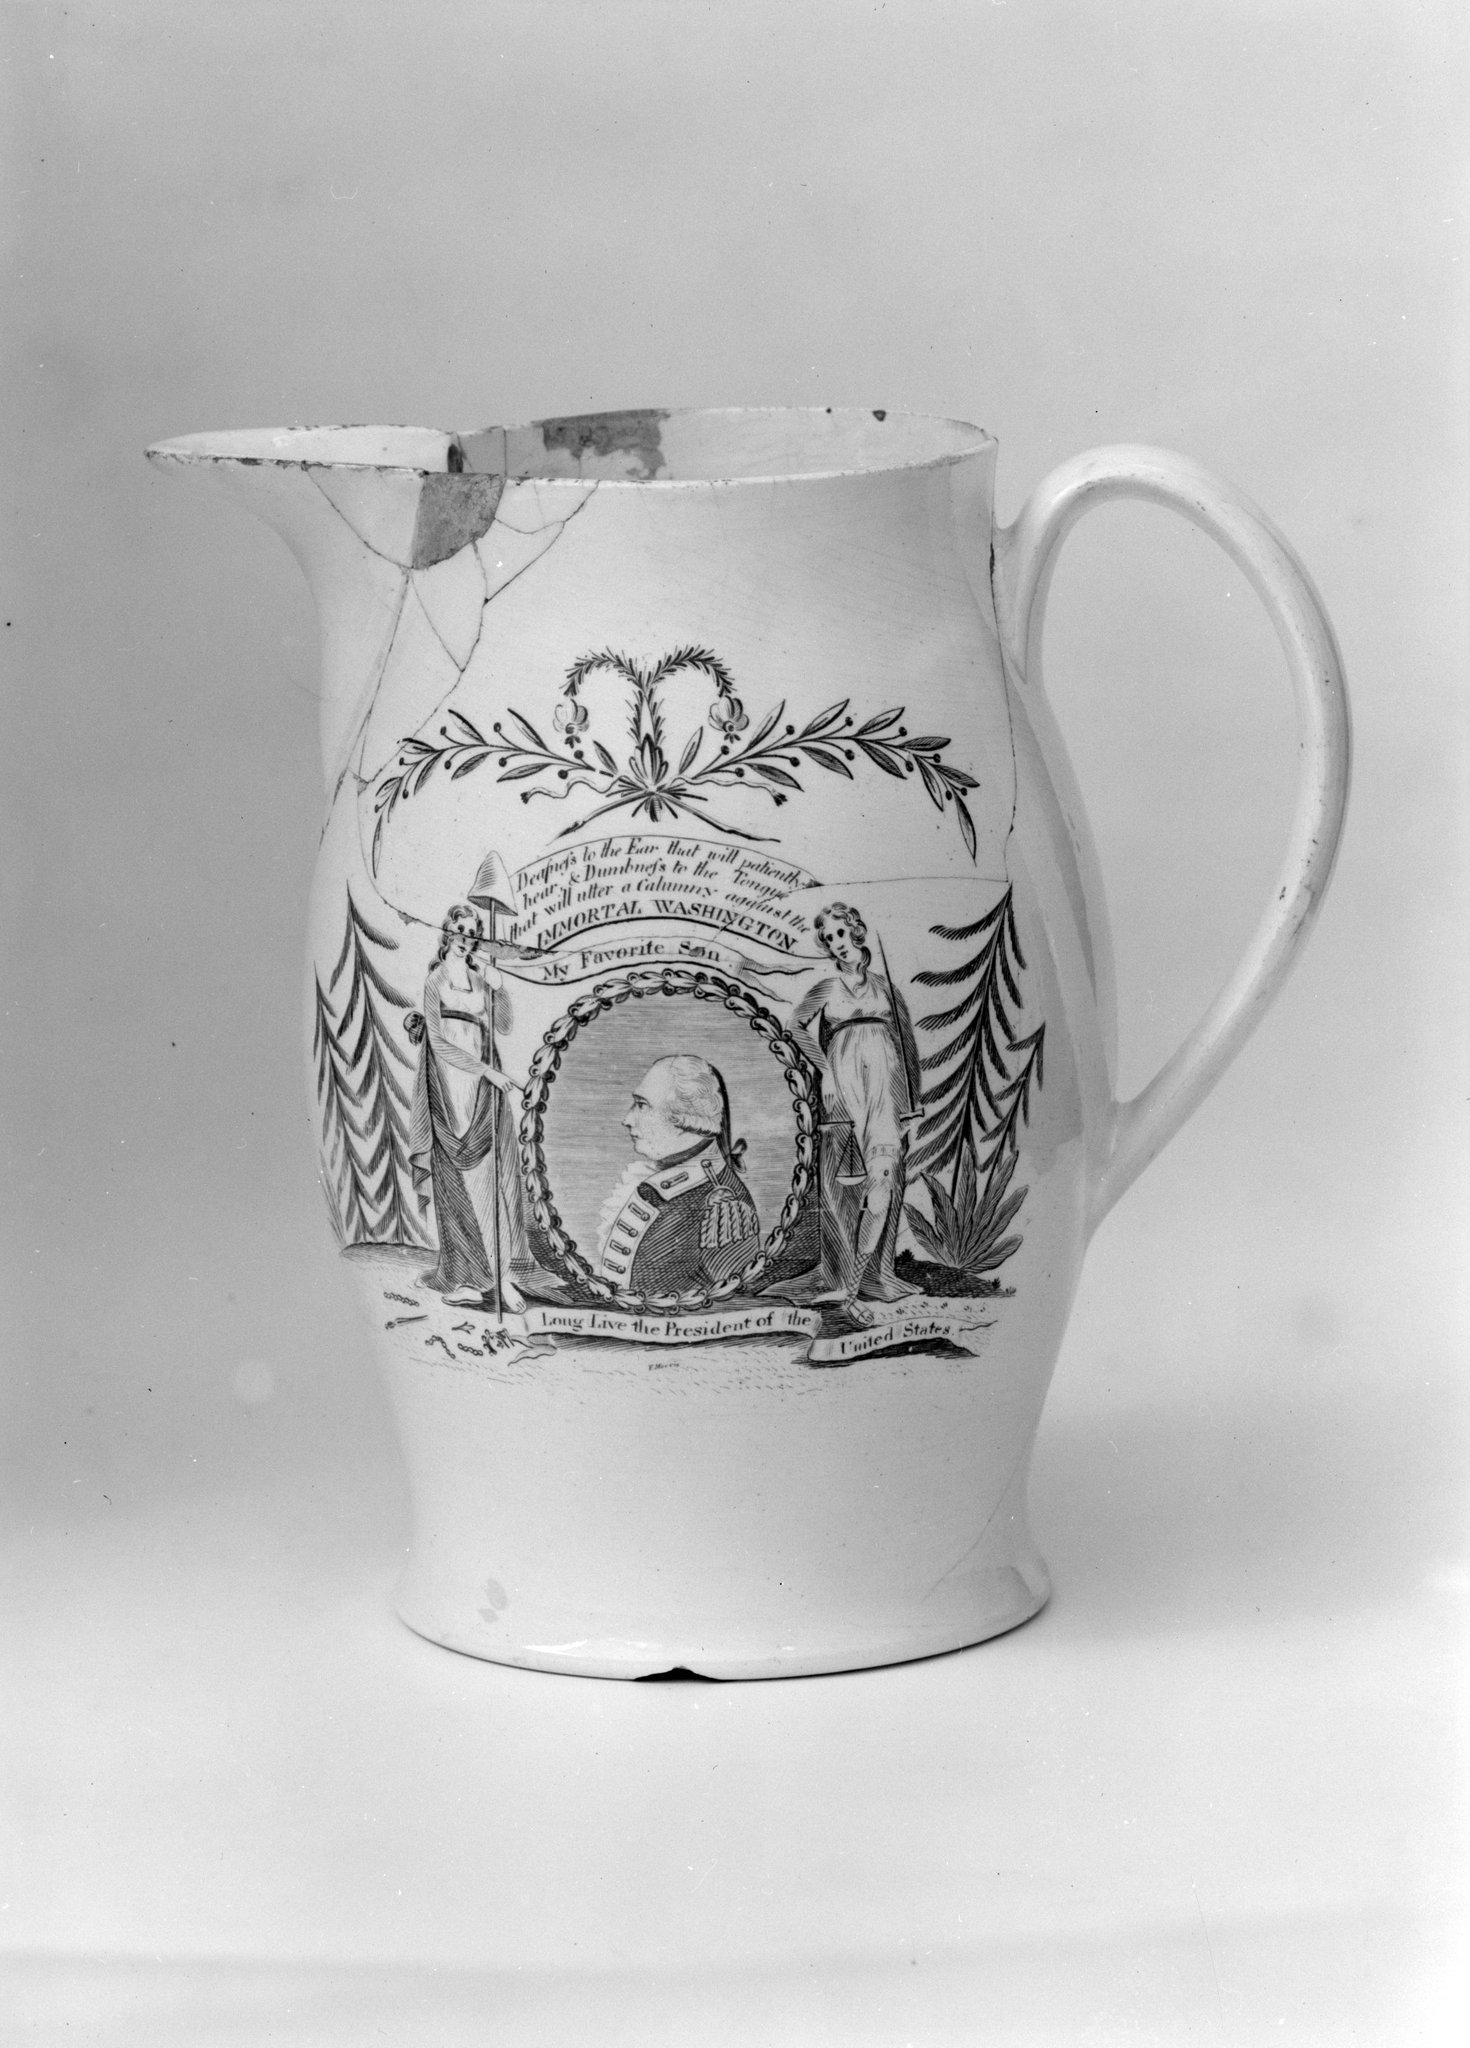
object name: jug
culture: british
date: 1770-1800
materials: earthenware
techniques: transfer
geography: england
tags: george washington,men